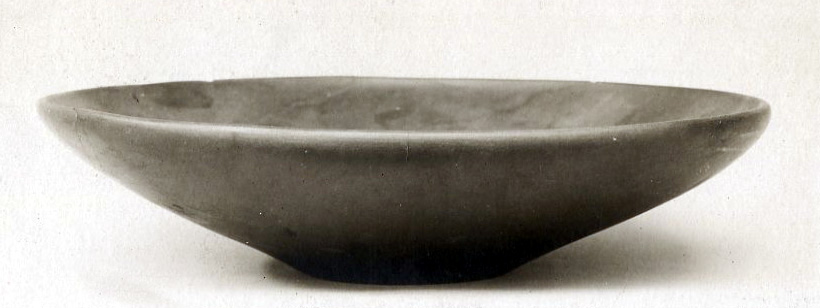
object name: bowl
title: Shallow bowl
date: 2960-2649 BCE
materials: wood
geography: egypt